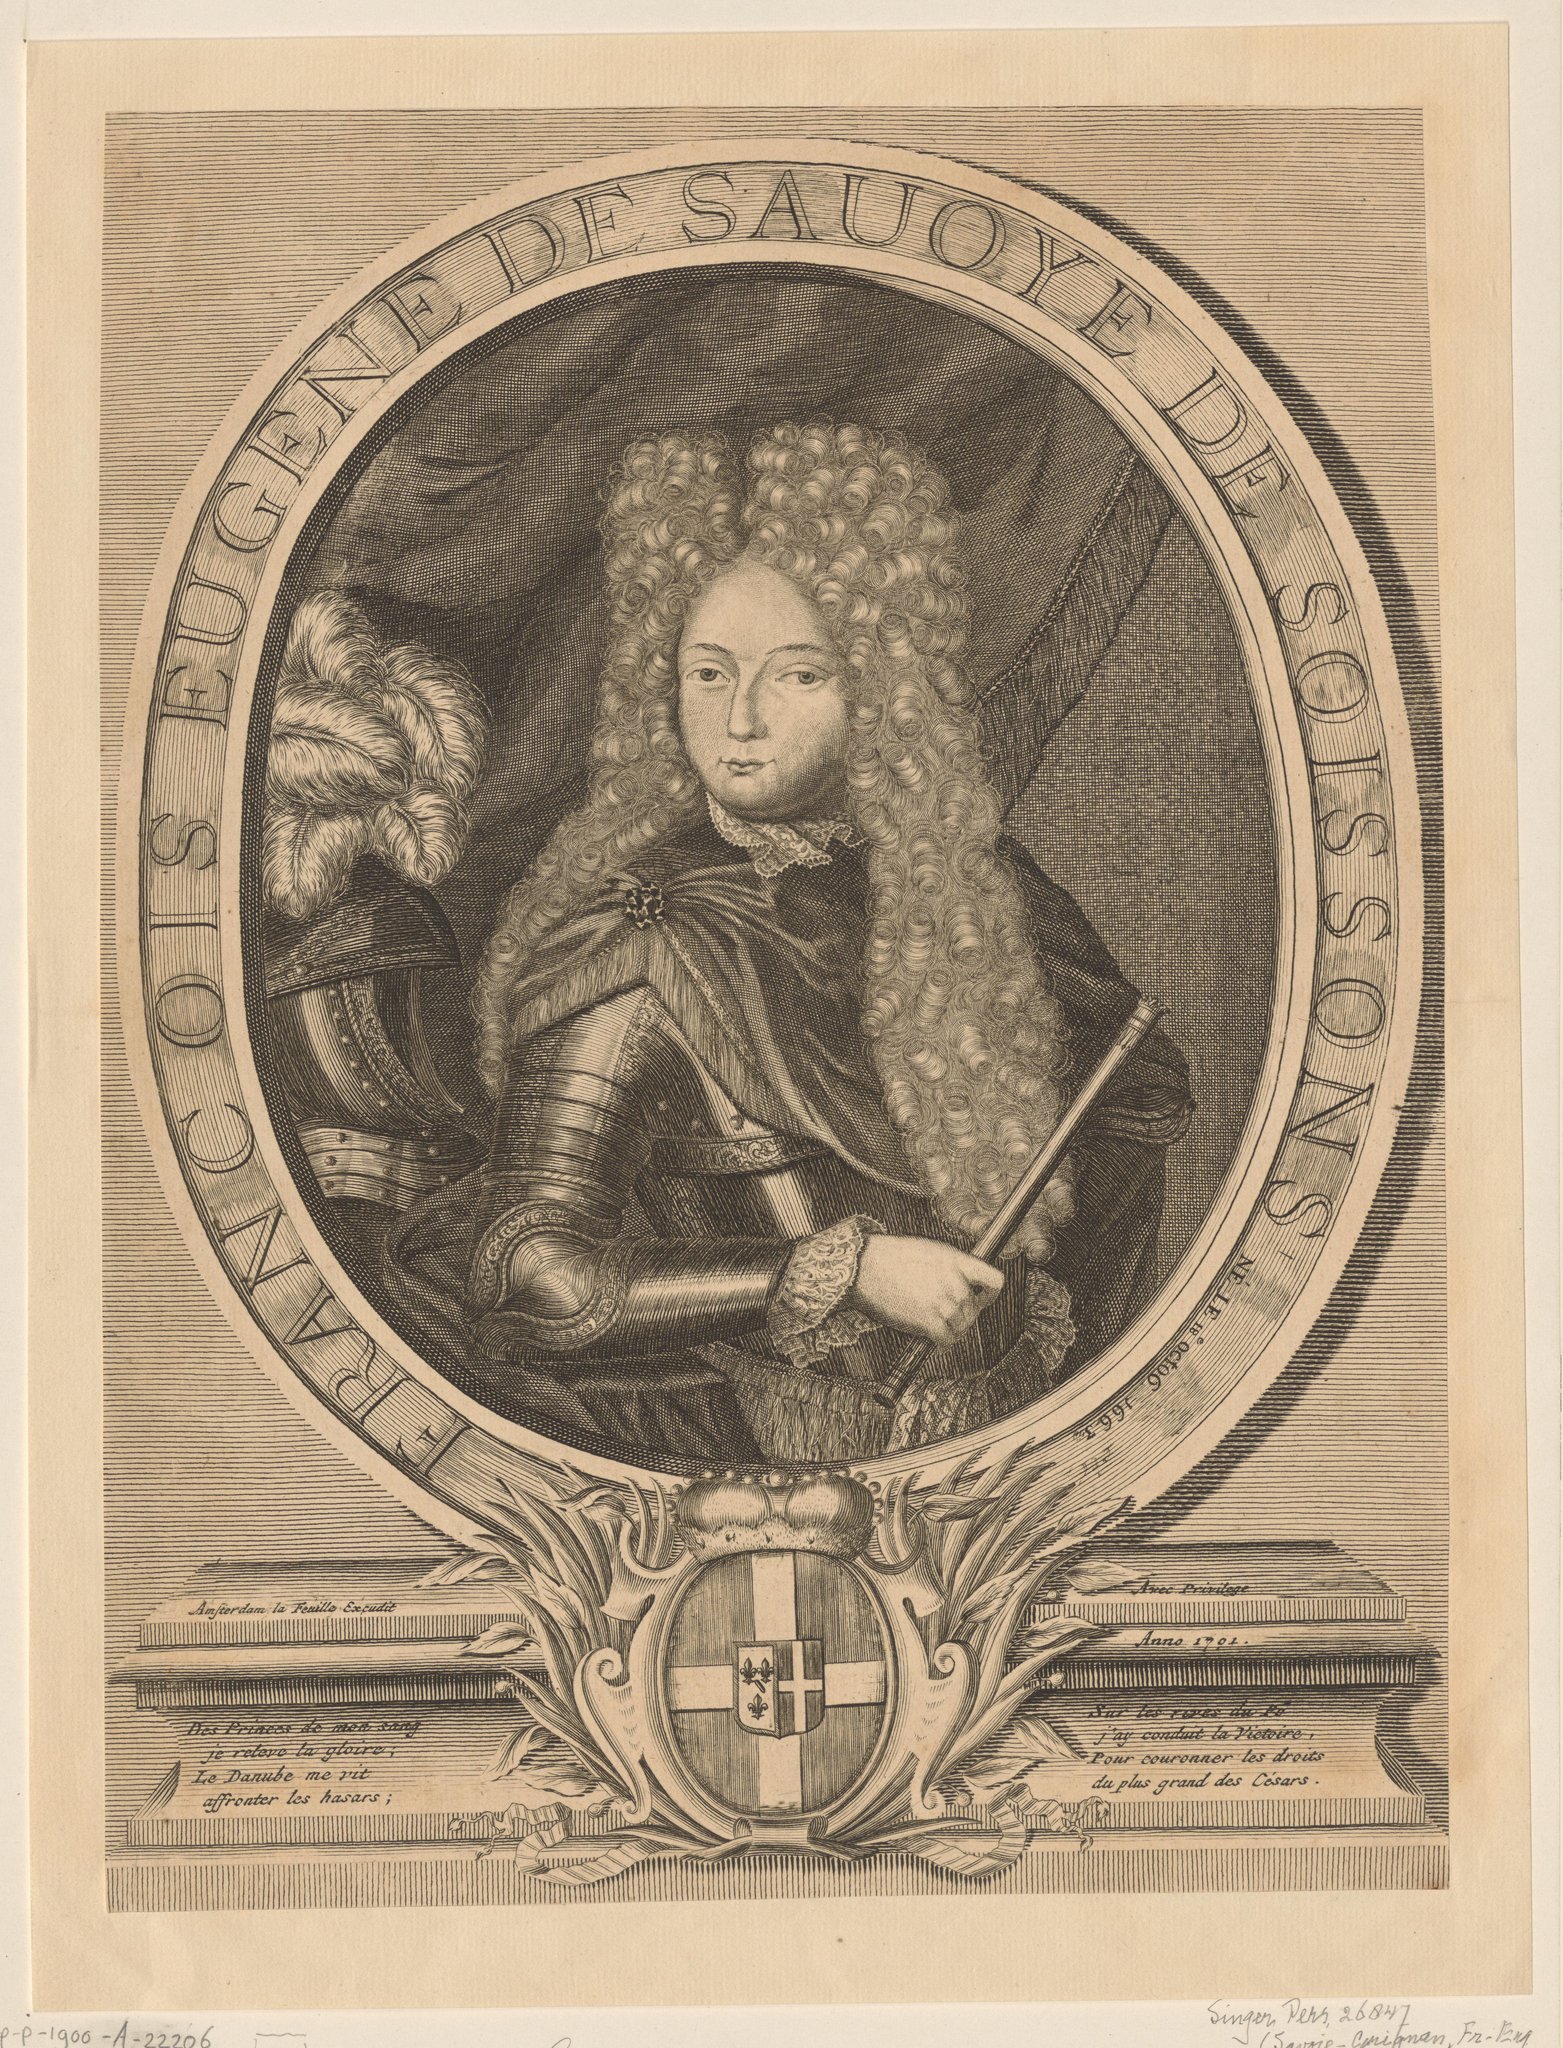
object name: print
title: Portret van Eugenius van Savoye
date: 1701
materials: paper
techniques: engraving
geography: amsterdam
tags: paris, vienna, eugenius van savoye, armour, historical persons, armorial bearing, heraldry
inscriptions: collector's mark: Lugt 2228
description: Met achtregelig vers in het Frans onder de prent.